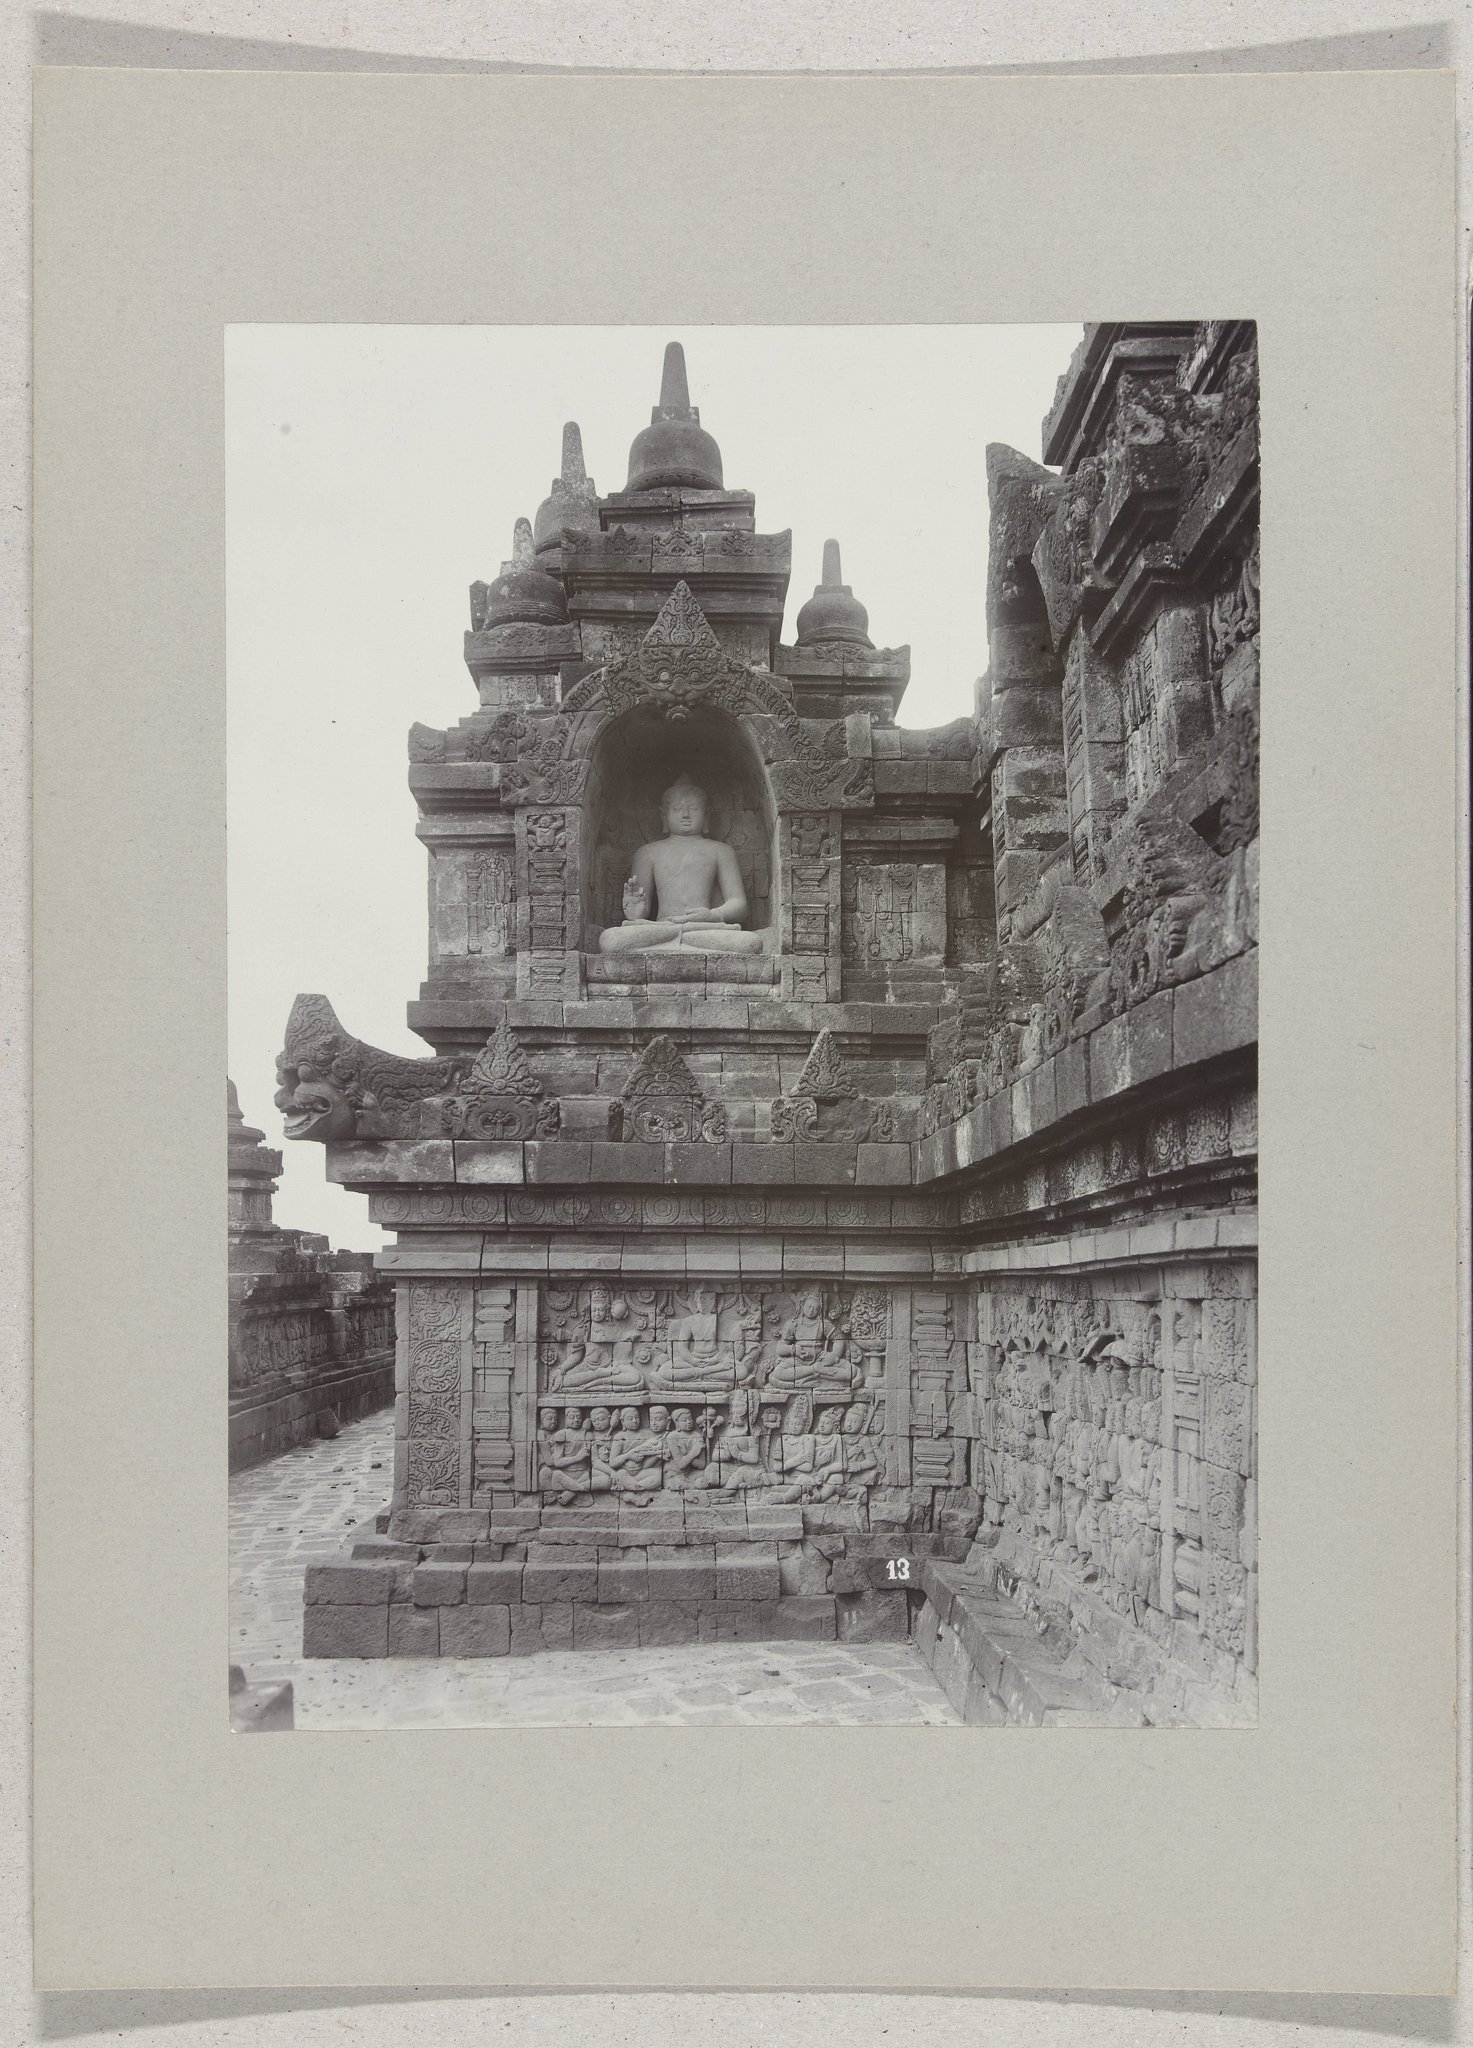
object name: photograph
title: 80. Boroboedoer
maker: onnes kurkdjian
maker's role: fotograaf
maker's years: 1851-1903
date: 1895-1915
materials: cardboard, paper, photographic support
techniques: gelatin silver print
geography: magelang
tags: borobudur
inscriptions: number: ‘13’, annotation: ‘80. Boroboedoer’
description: Gaanderij van de Borobudur (Boroboedoer) met een beeld van Boeddha, nabij Magelang, Nederlands-Indië